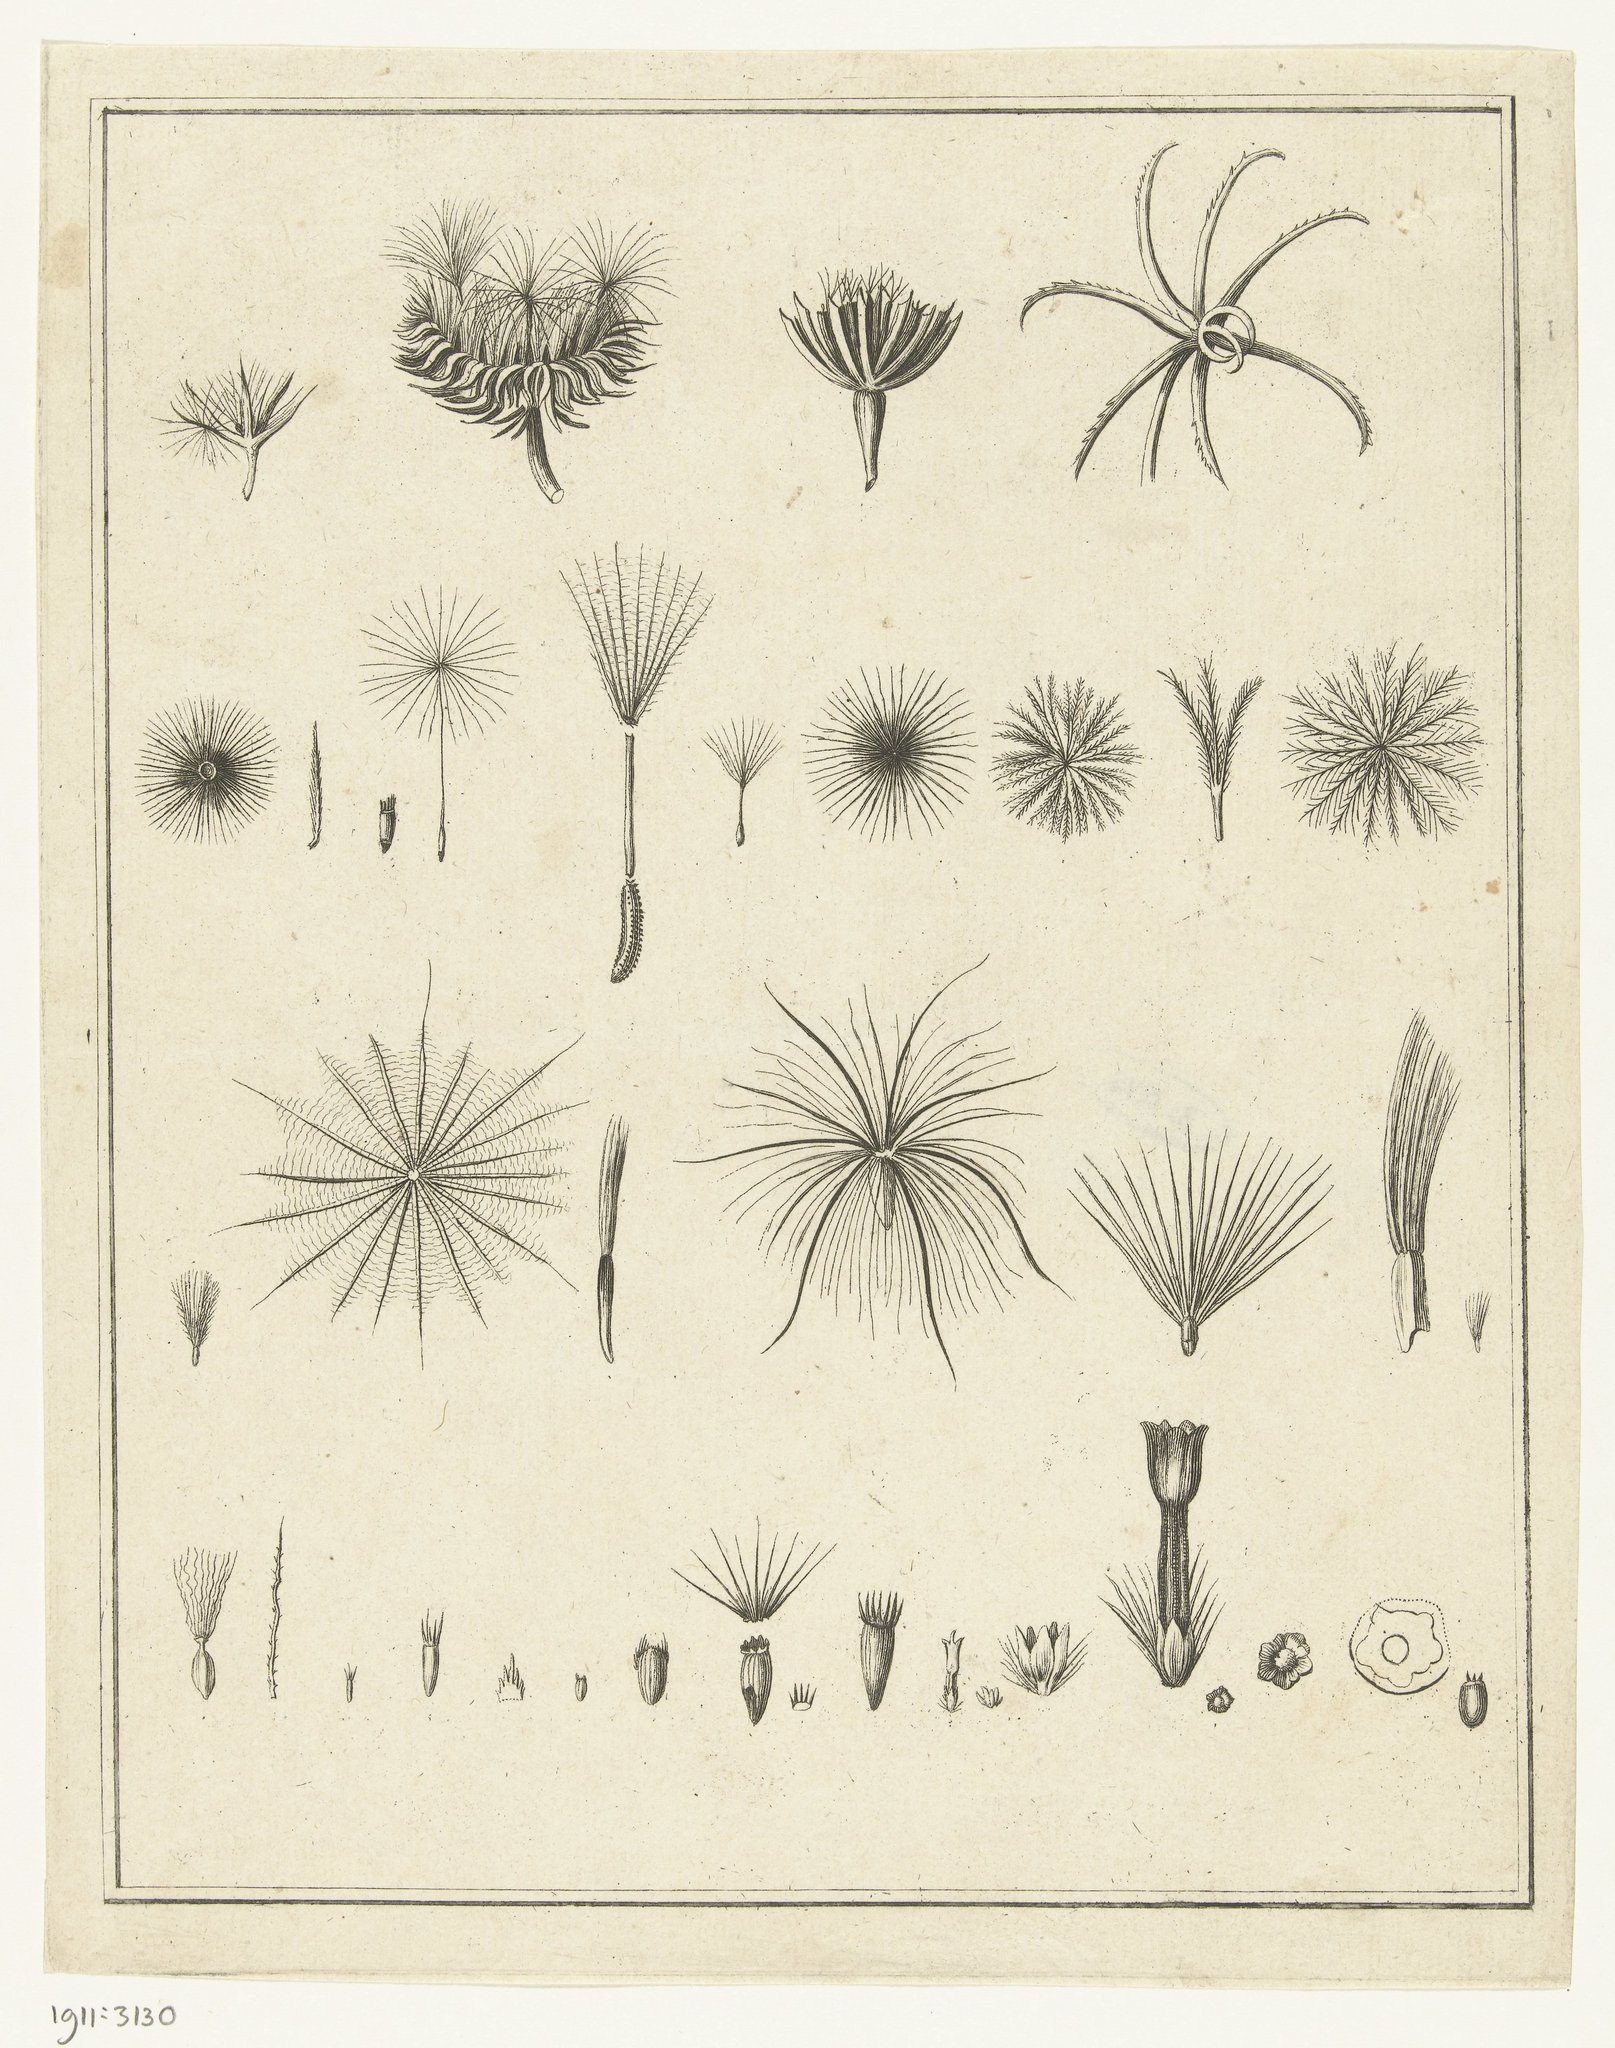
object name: print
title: Bloemen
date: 1751-1822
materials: paper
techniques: etching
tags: flowers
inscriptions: collector's mark: Lugt 2228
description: Verschillende pluizen en zaden van bloemen.